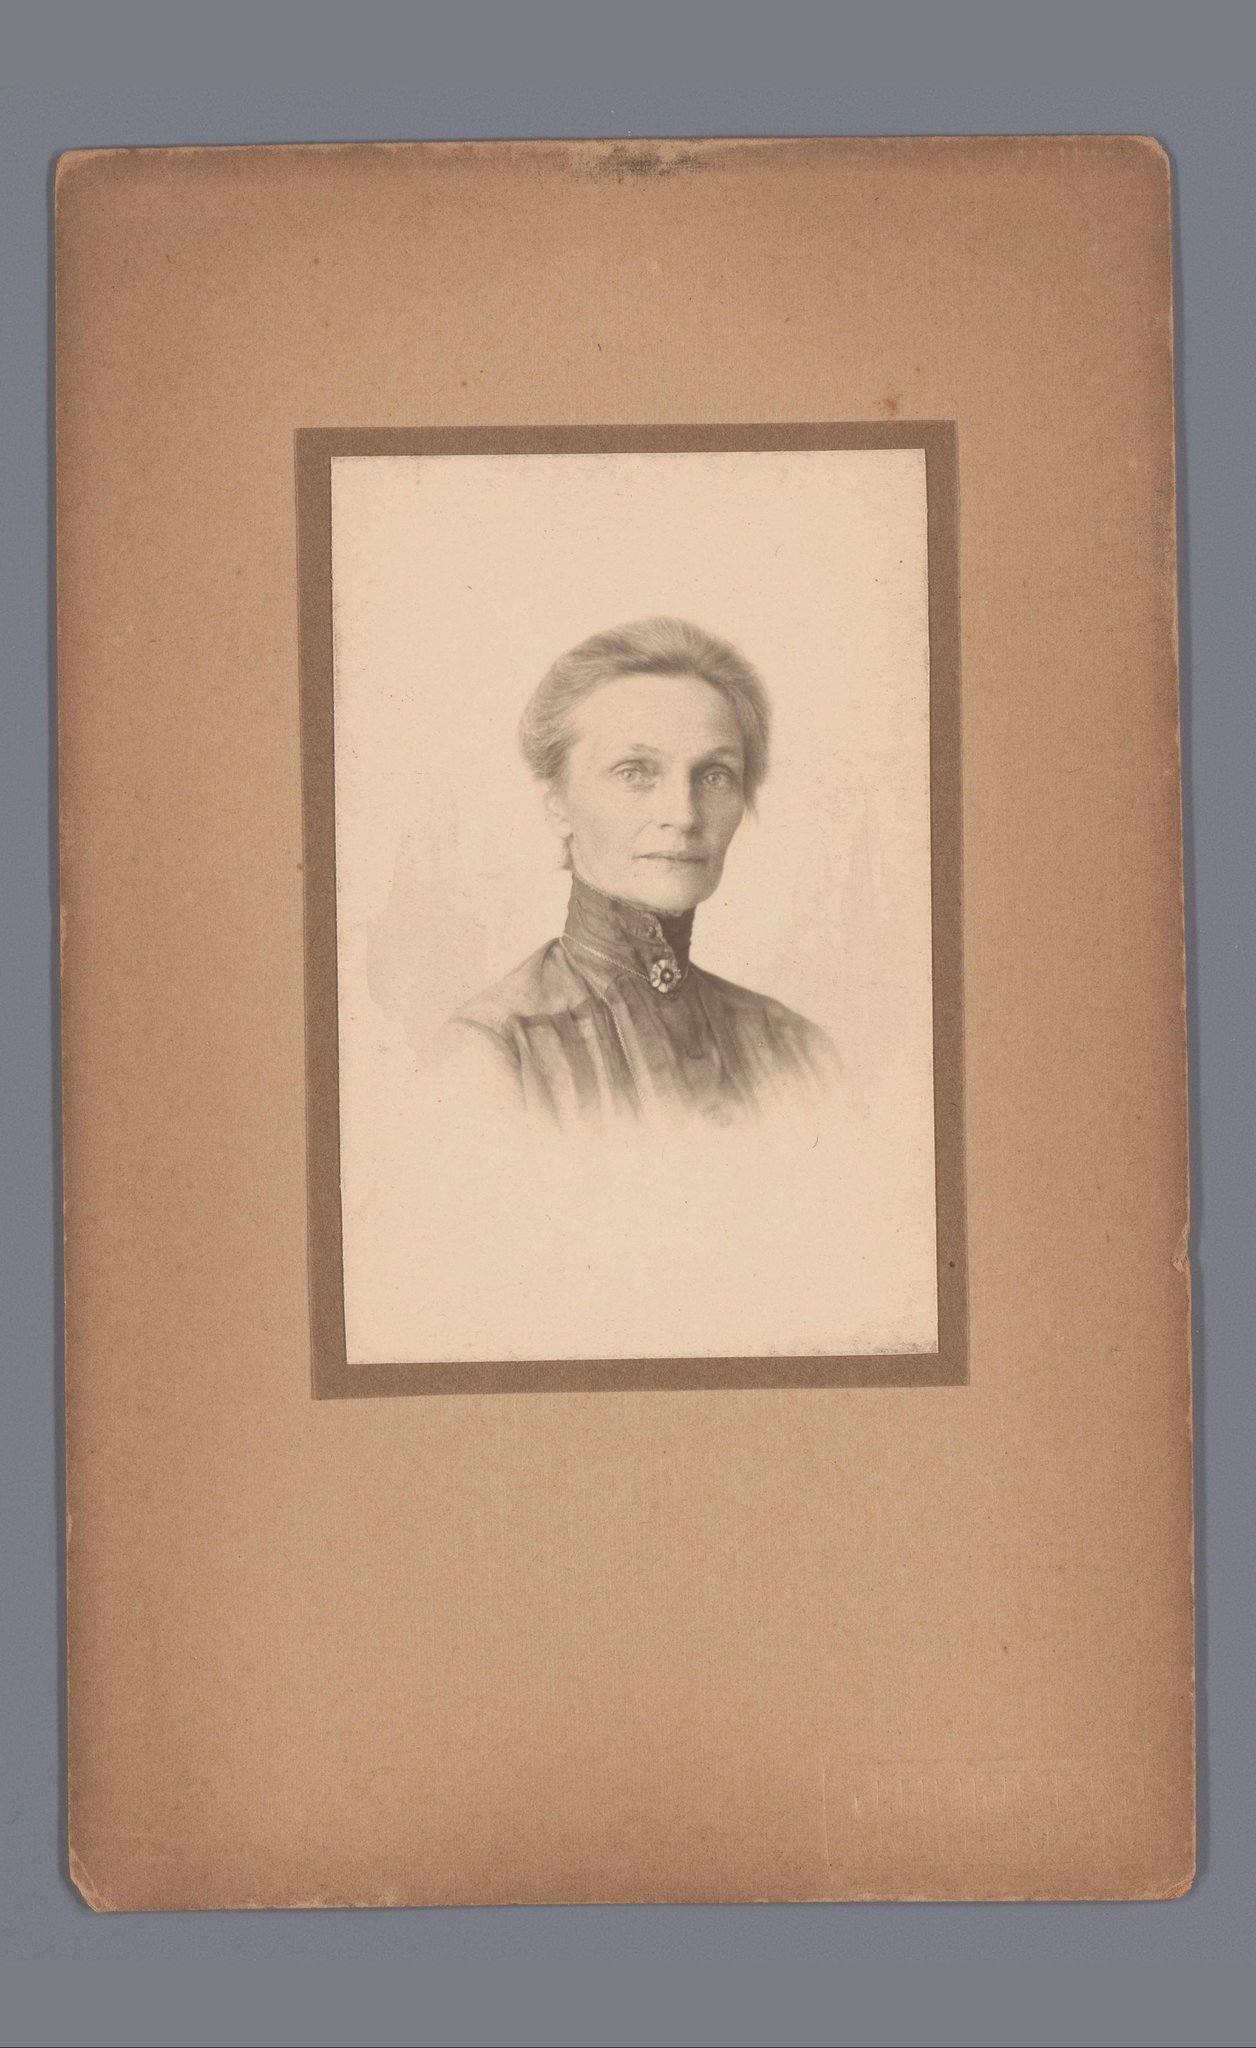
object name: photograph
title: Portret van Jacqueline E. van der Waals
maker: johannes maria petrus antonius huijsen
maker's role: fotograaf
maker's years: 1877-1959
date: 1900-1940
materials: cardboard, photographic support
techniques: collodion silver print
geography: amsterdam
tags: the hague, amsterdam, historical persons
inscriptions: workshop stamp: ‘J. Huijsen/ Amsterdam’